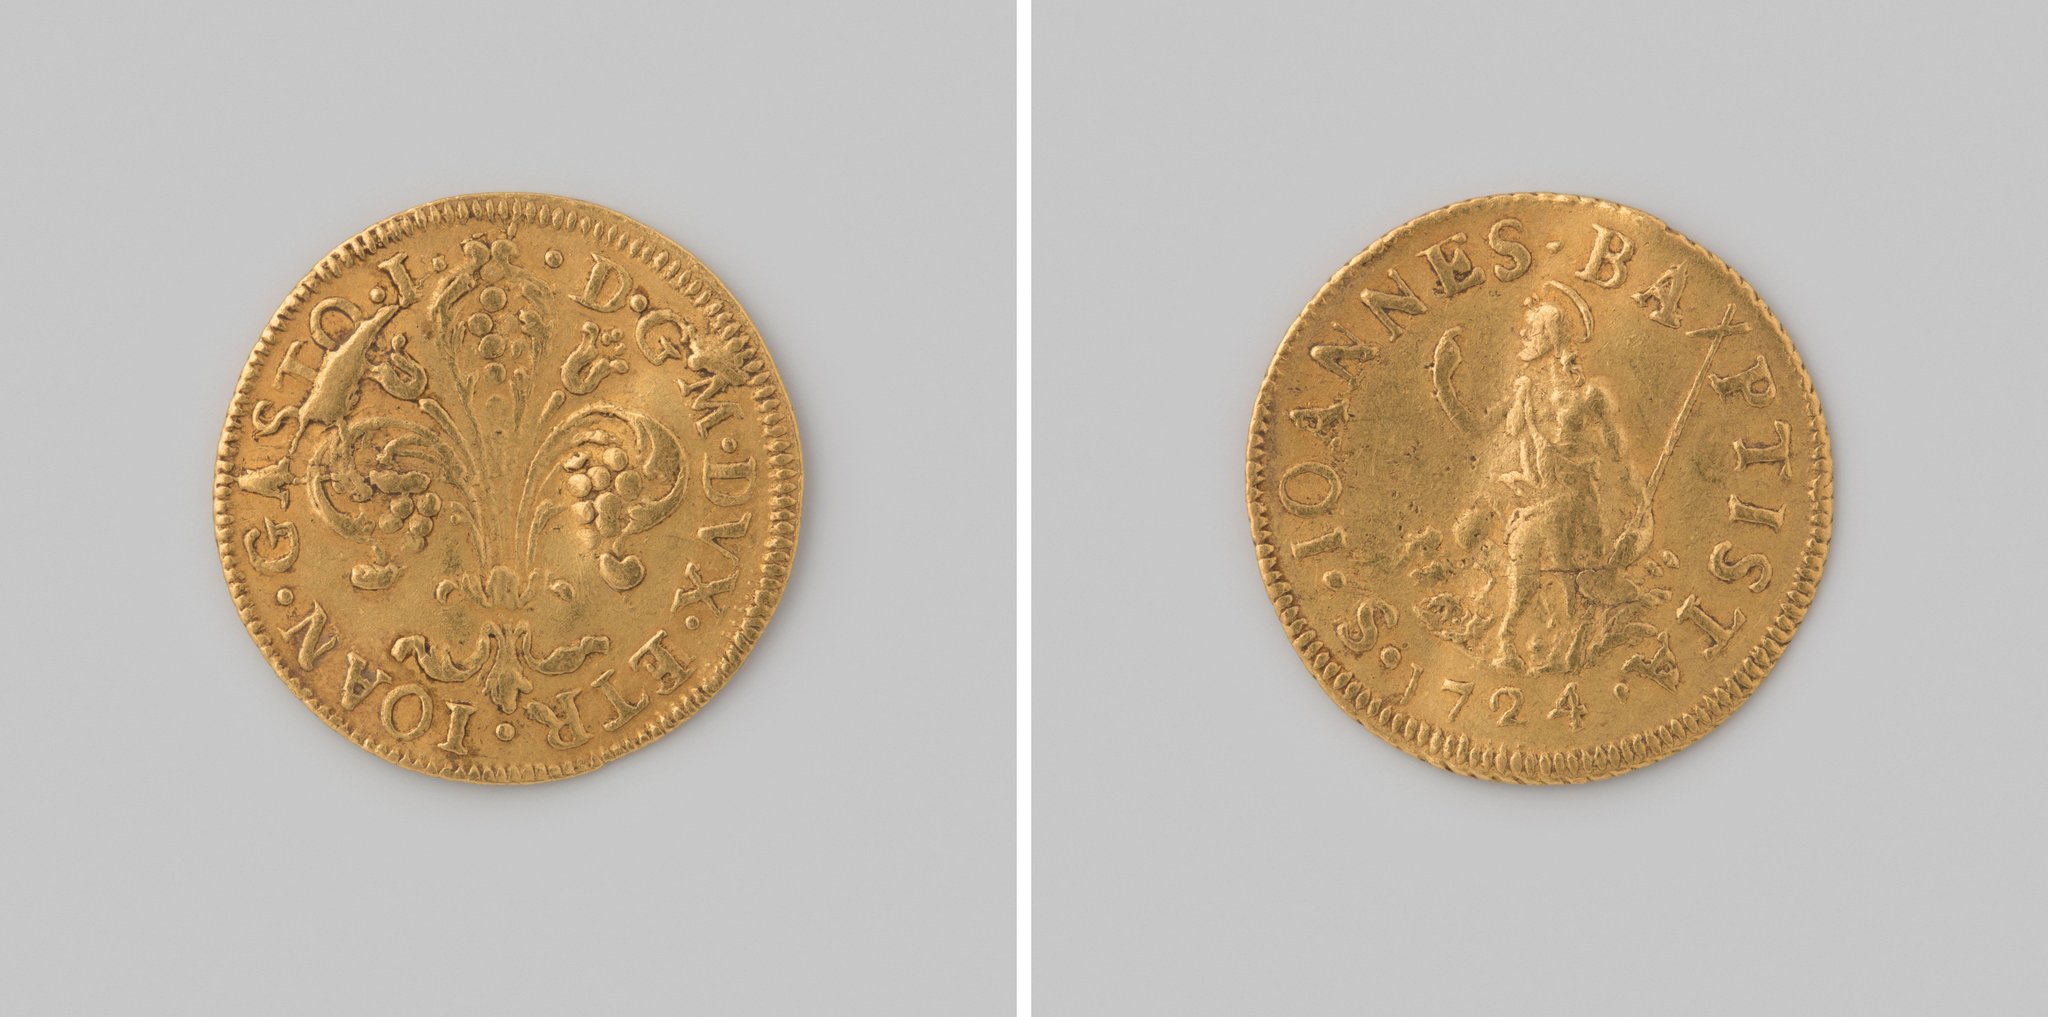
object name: coin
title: Groothertogdom Toscane, Florence ,Fiorino of zecchino, Giovan Gastone dei Medici, 1723-1737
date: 1724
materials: gold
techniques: striking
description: Gouden munt. Voorzijde: lelie. Keerzijde: heilige Johannes met kruis in de linkerhand, naar links lopend. Jaartal onderaan. Kabelrand. NB: onregelmatigheden op voorzijde van het muntplaatje.